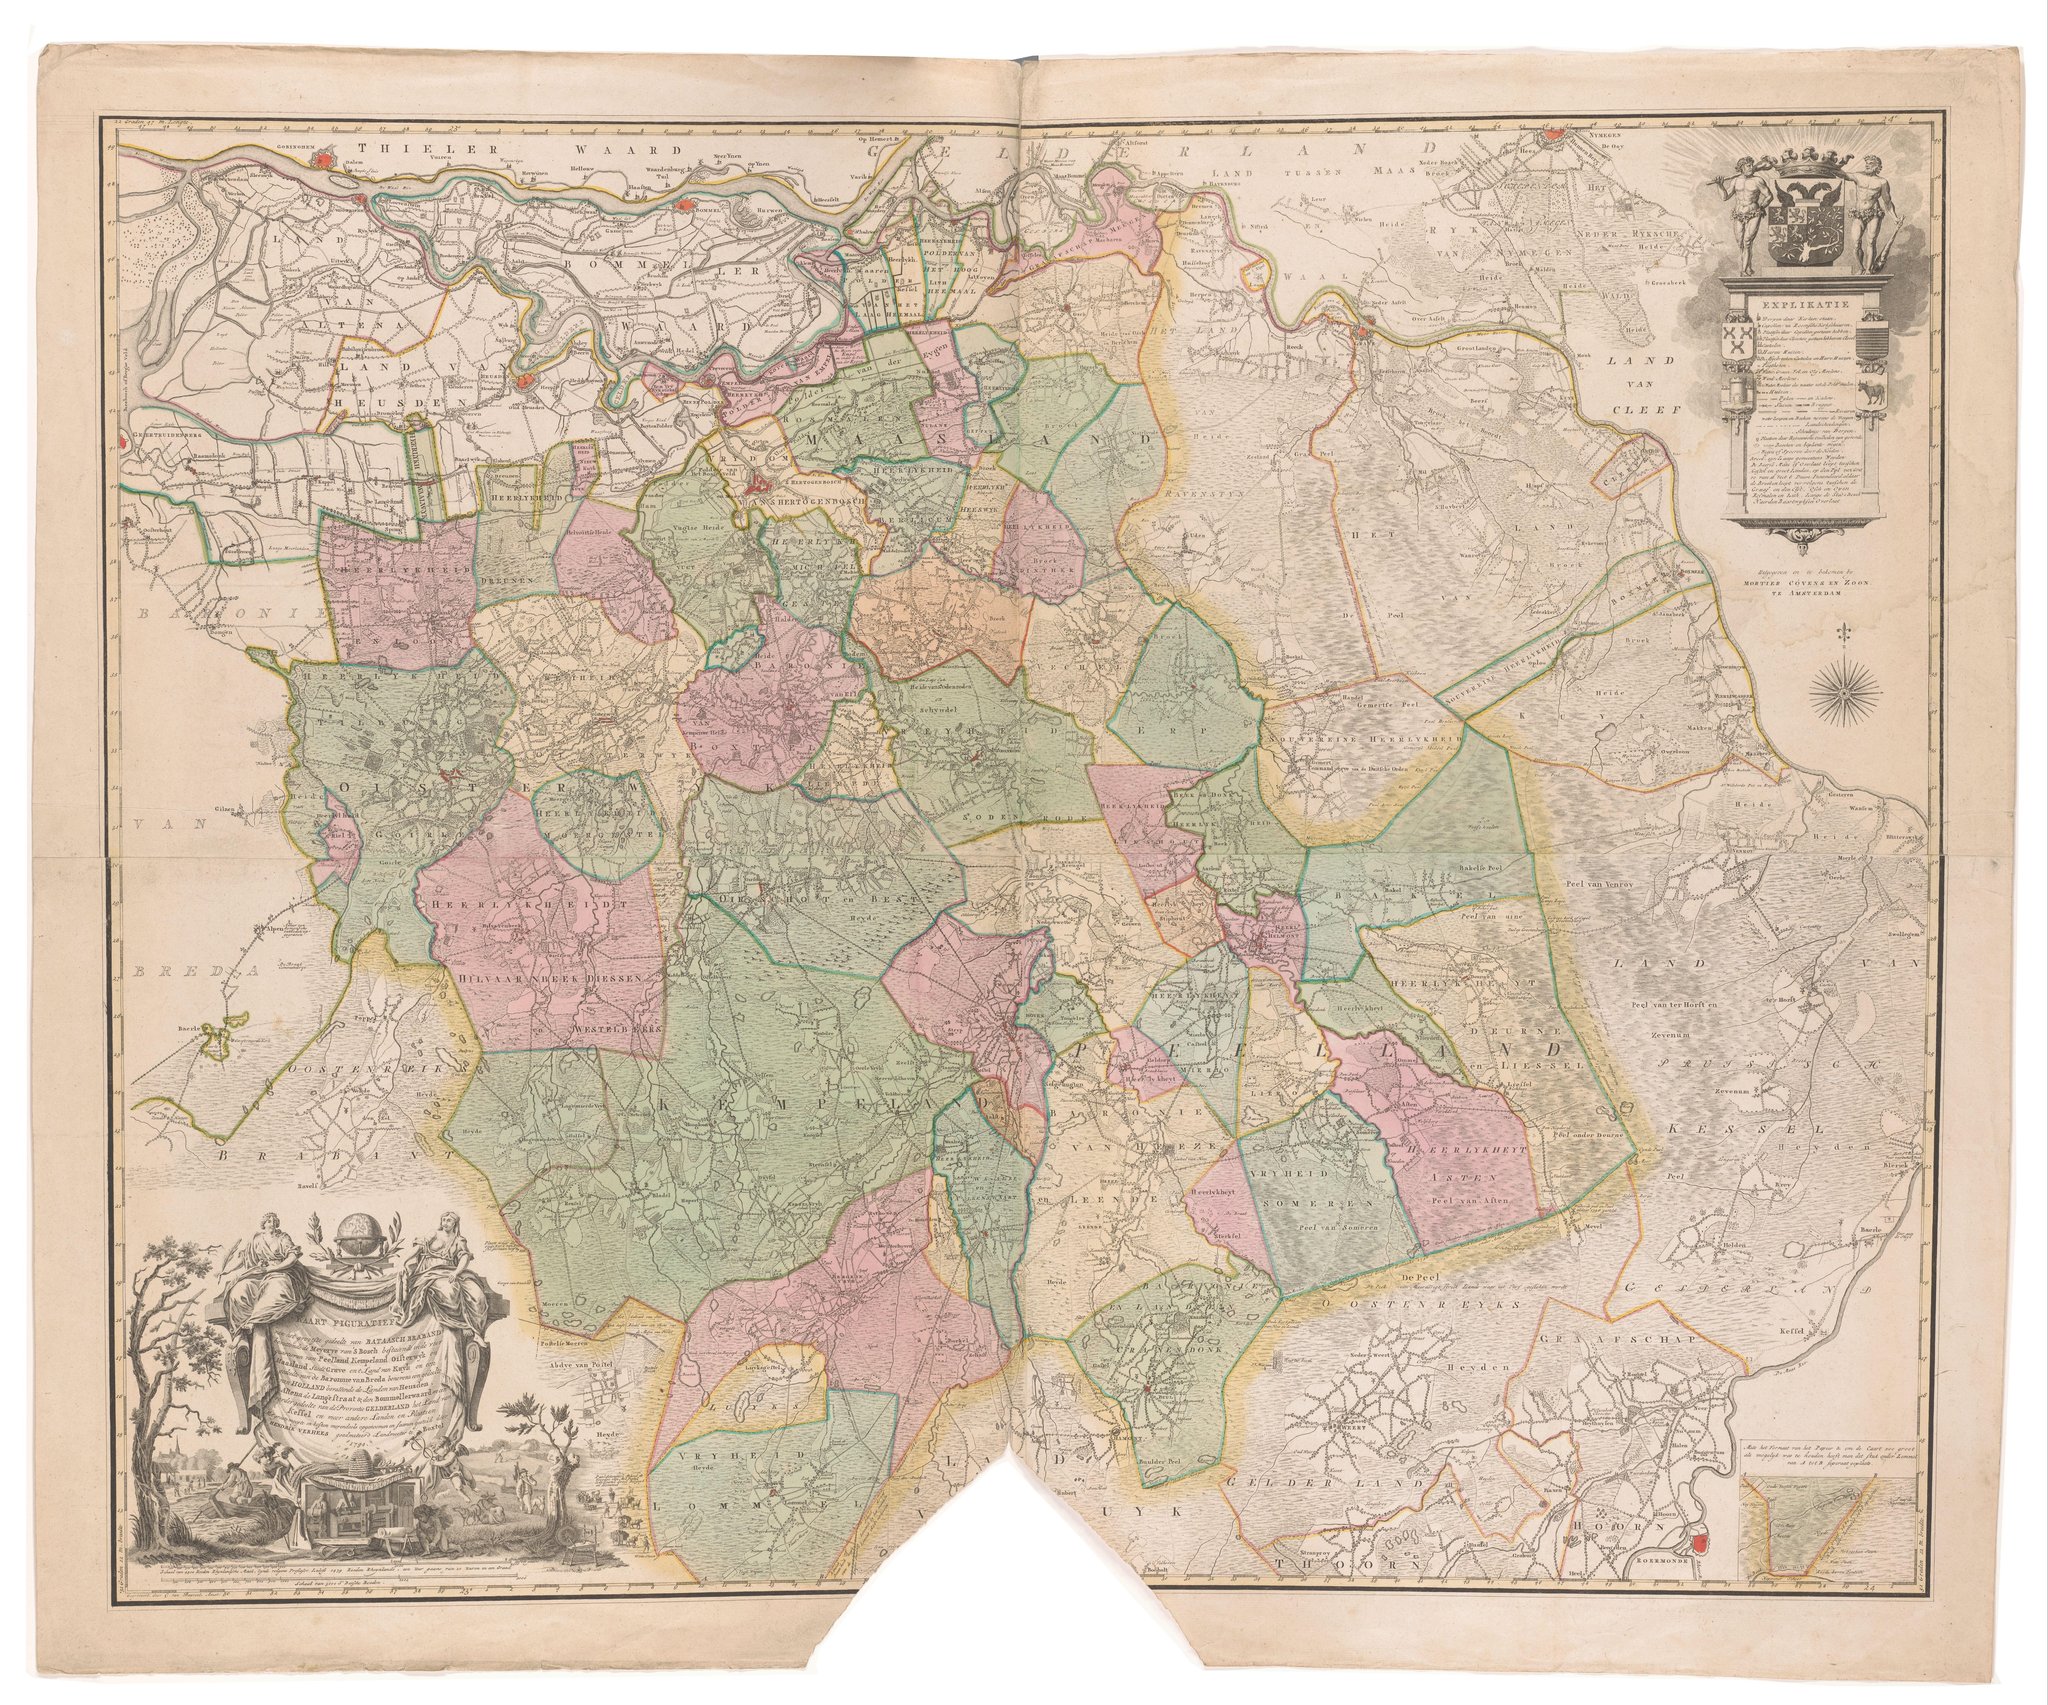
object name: print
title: Kaart van Brabant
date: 1794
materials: paper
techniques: engraving, etching, hand coloring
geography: amsterdam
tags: coat of arms (as symbol of the state, etc.) (+ city; municipal), maps of separate countries or regions, wild man, wodewose, woodehouse, herding, herdsman, herdswoman, shepherd, shepherdess, cowherd, etc., hunters hunting (n.b.: in 1988-1990 this notation denoted the concept of 43c11421 'hunters resting during the hunt'), spinning-wheel, rowing-boat, canoe, etc., bee-hive, cupids: 'amores', 'amoretti', 'putti', coat of arms (as symbol of the state, etc.) (+ province; provincial), brabant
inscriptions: collector's mark: Lugt 2228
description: Kaart van Brabant. Linksonder de titelcartouche met daaronder twee schaalstokken: Schaal van 4500 Roeden Rhynlandsche Maal, zijnde volgens Professor Lulofs 1479 Roeden Rheynlands, een Uur gaans van 20 Uuren in een Graad / Schaal van 3000 S' Bossche Roeden. Rechtsboven een cartouche met de legenda. Daarboven het wapen van ’s-Hertogenbosch, geflankeerd door twee wildemannen. Op de linker pilaar van de cartouche de wapens van Peelland en Oisterwijk, op de rechter pilaar de wapens van Kempenland en Maasland. Rechtsonder een inzet met een kaart van het gebied ten zuiden van Lommel.